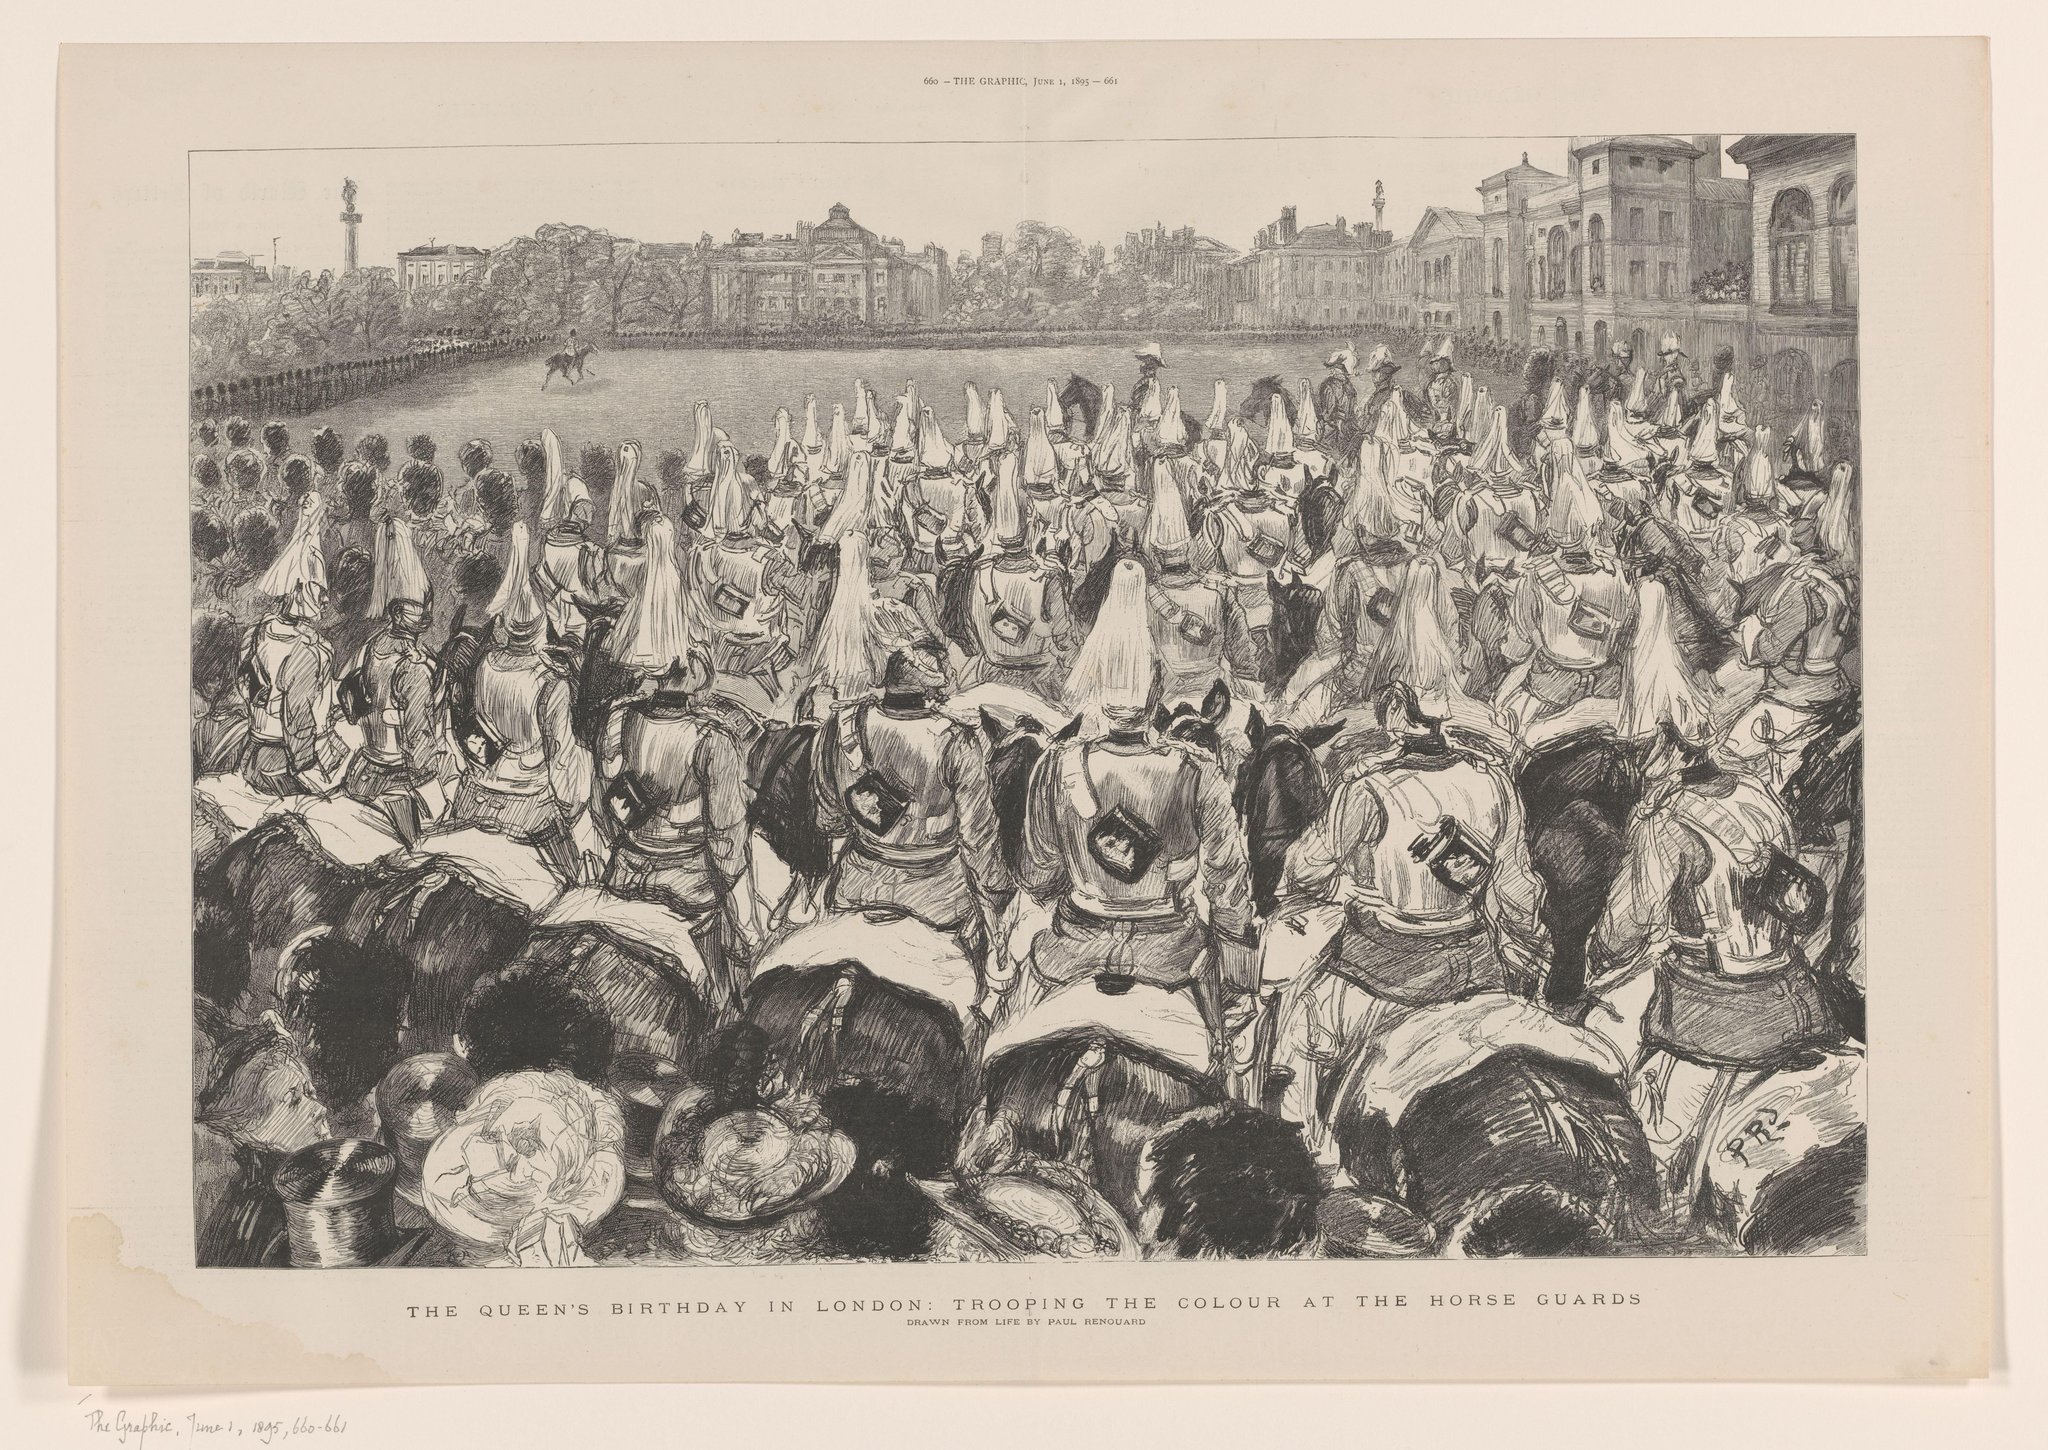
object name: print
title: The queen's birthday in London: Trooping the Colour at the horse guards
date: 1895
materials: paper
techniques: engraving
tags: military parade, pageant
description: Prent gebruikt in: The Graphic, 1 juni 1895, p. 660-661.